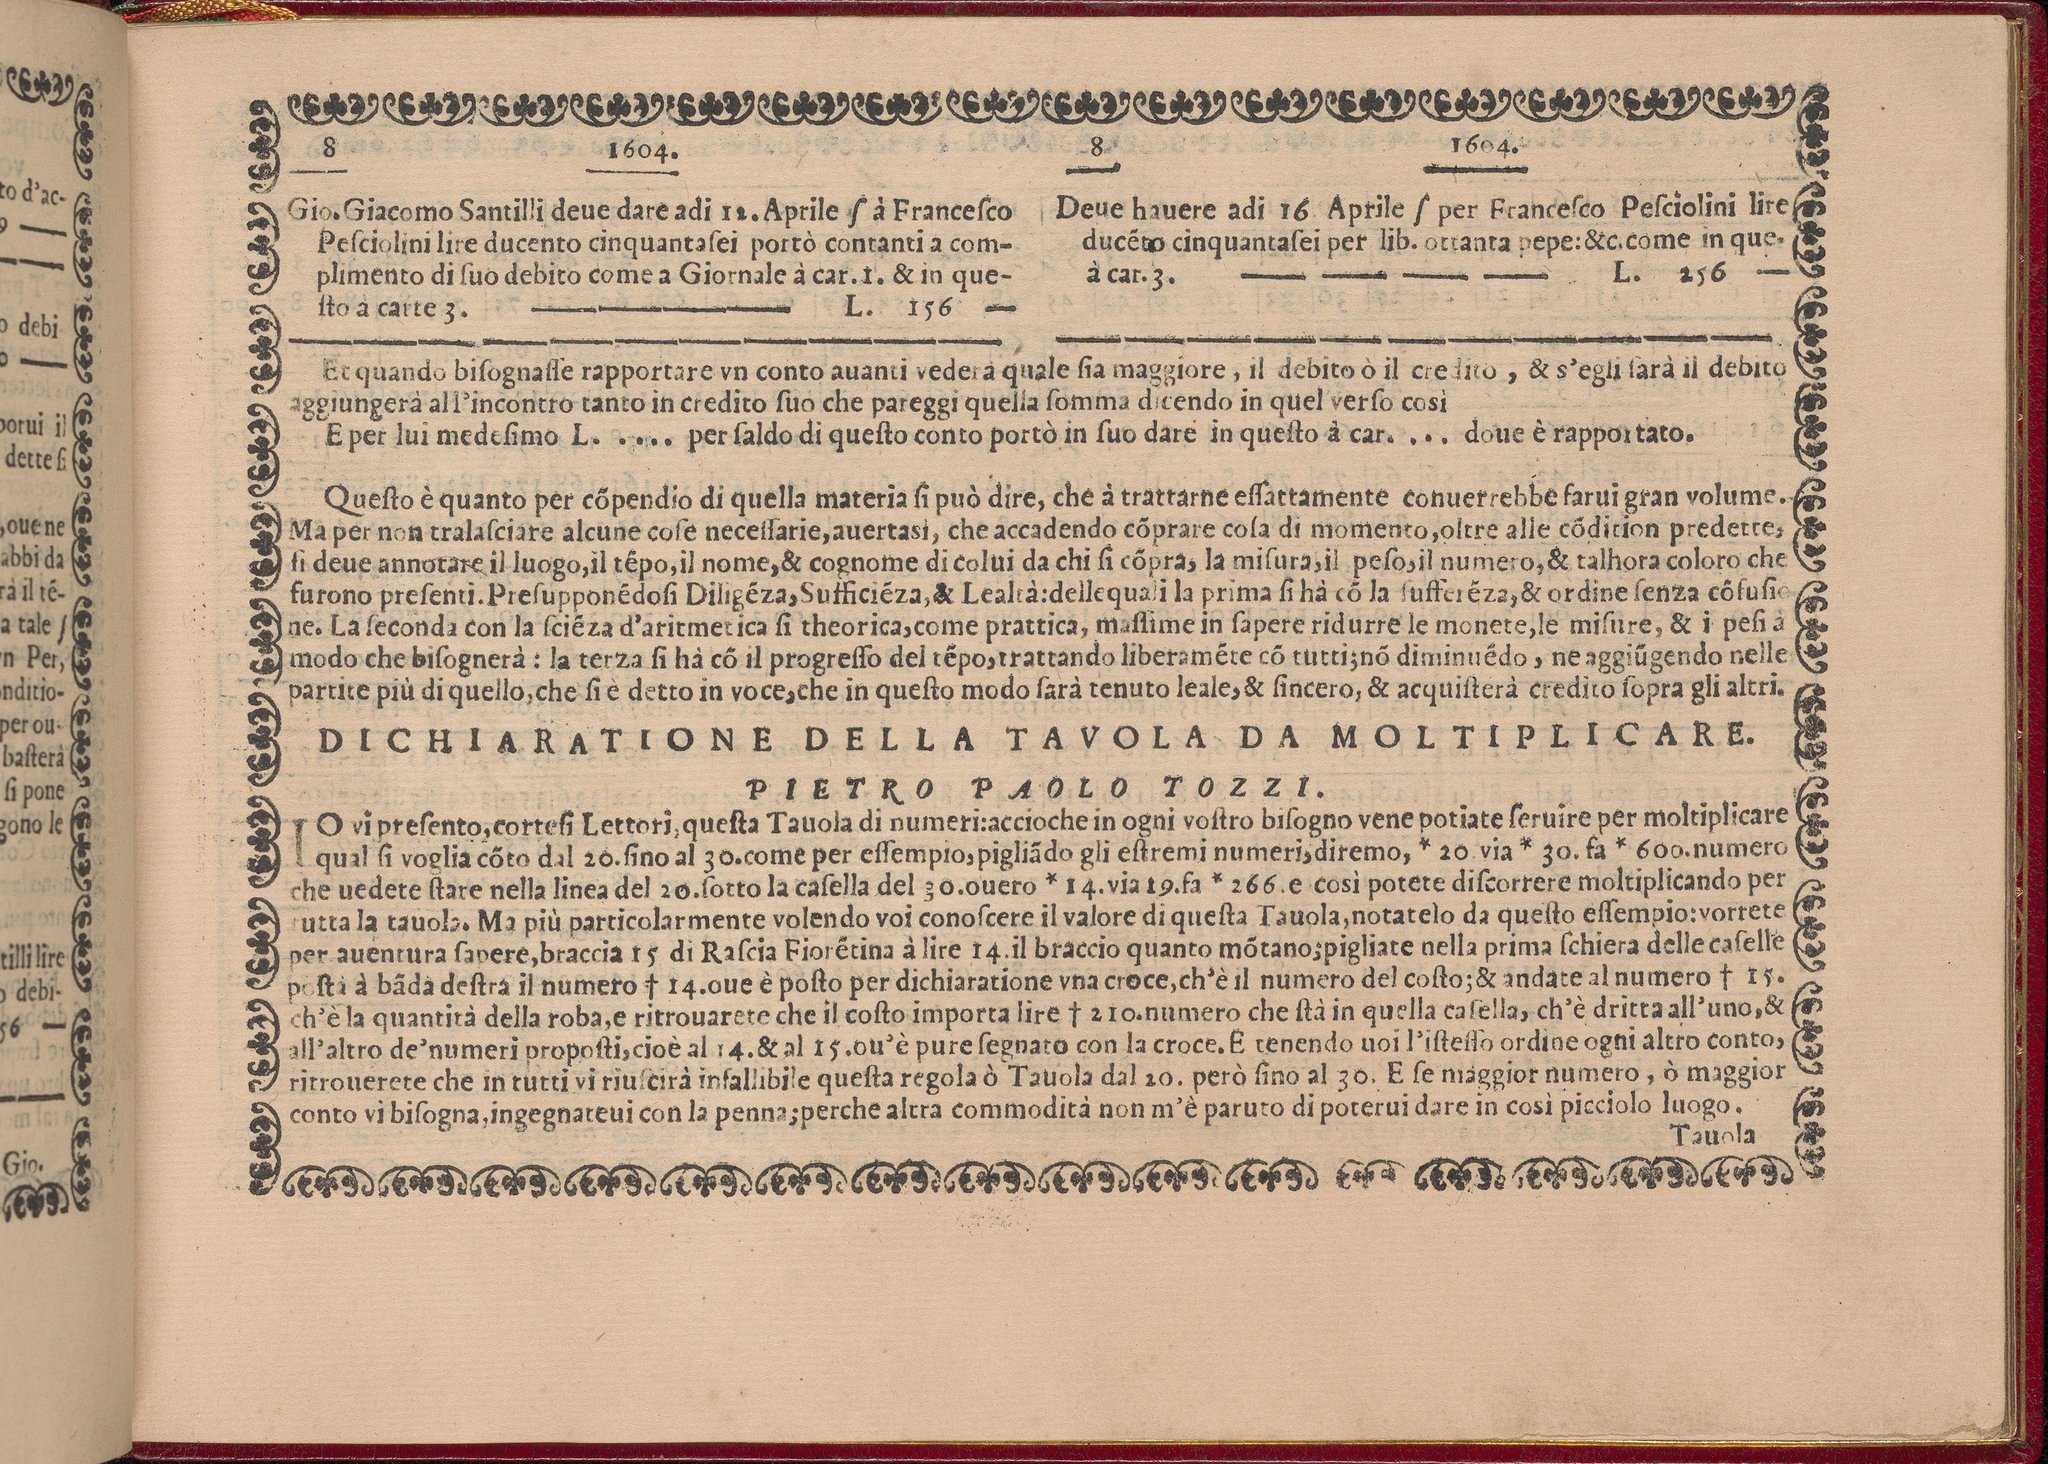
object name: book print ornament architecture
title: Ghirlanda: Di sei vaghi fiori scielti da piu famosi Giardini d'Italia, page 8 (recto)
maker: pietro paulo tozzi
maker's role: designer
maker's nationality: italian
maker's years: 1593-1628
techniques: drawing, etching